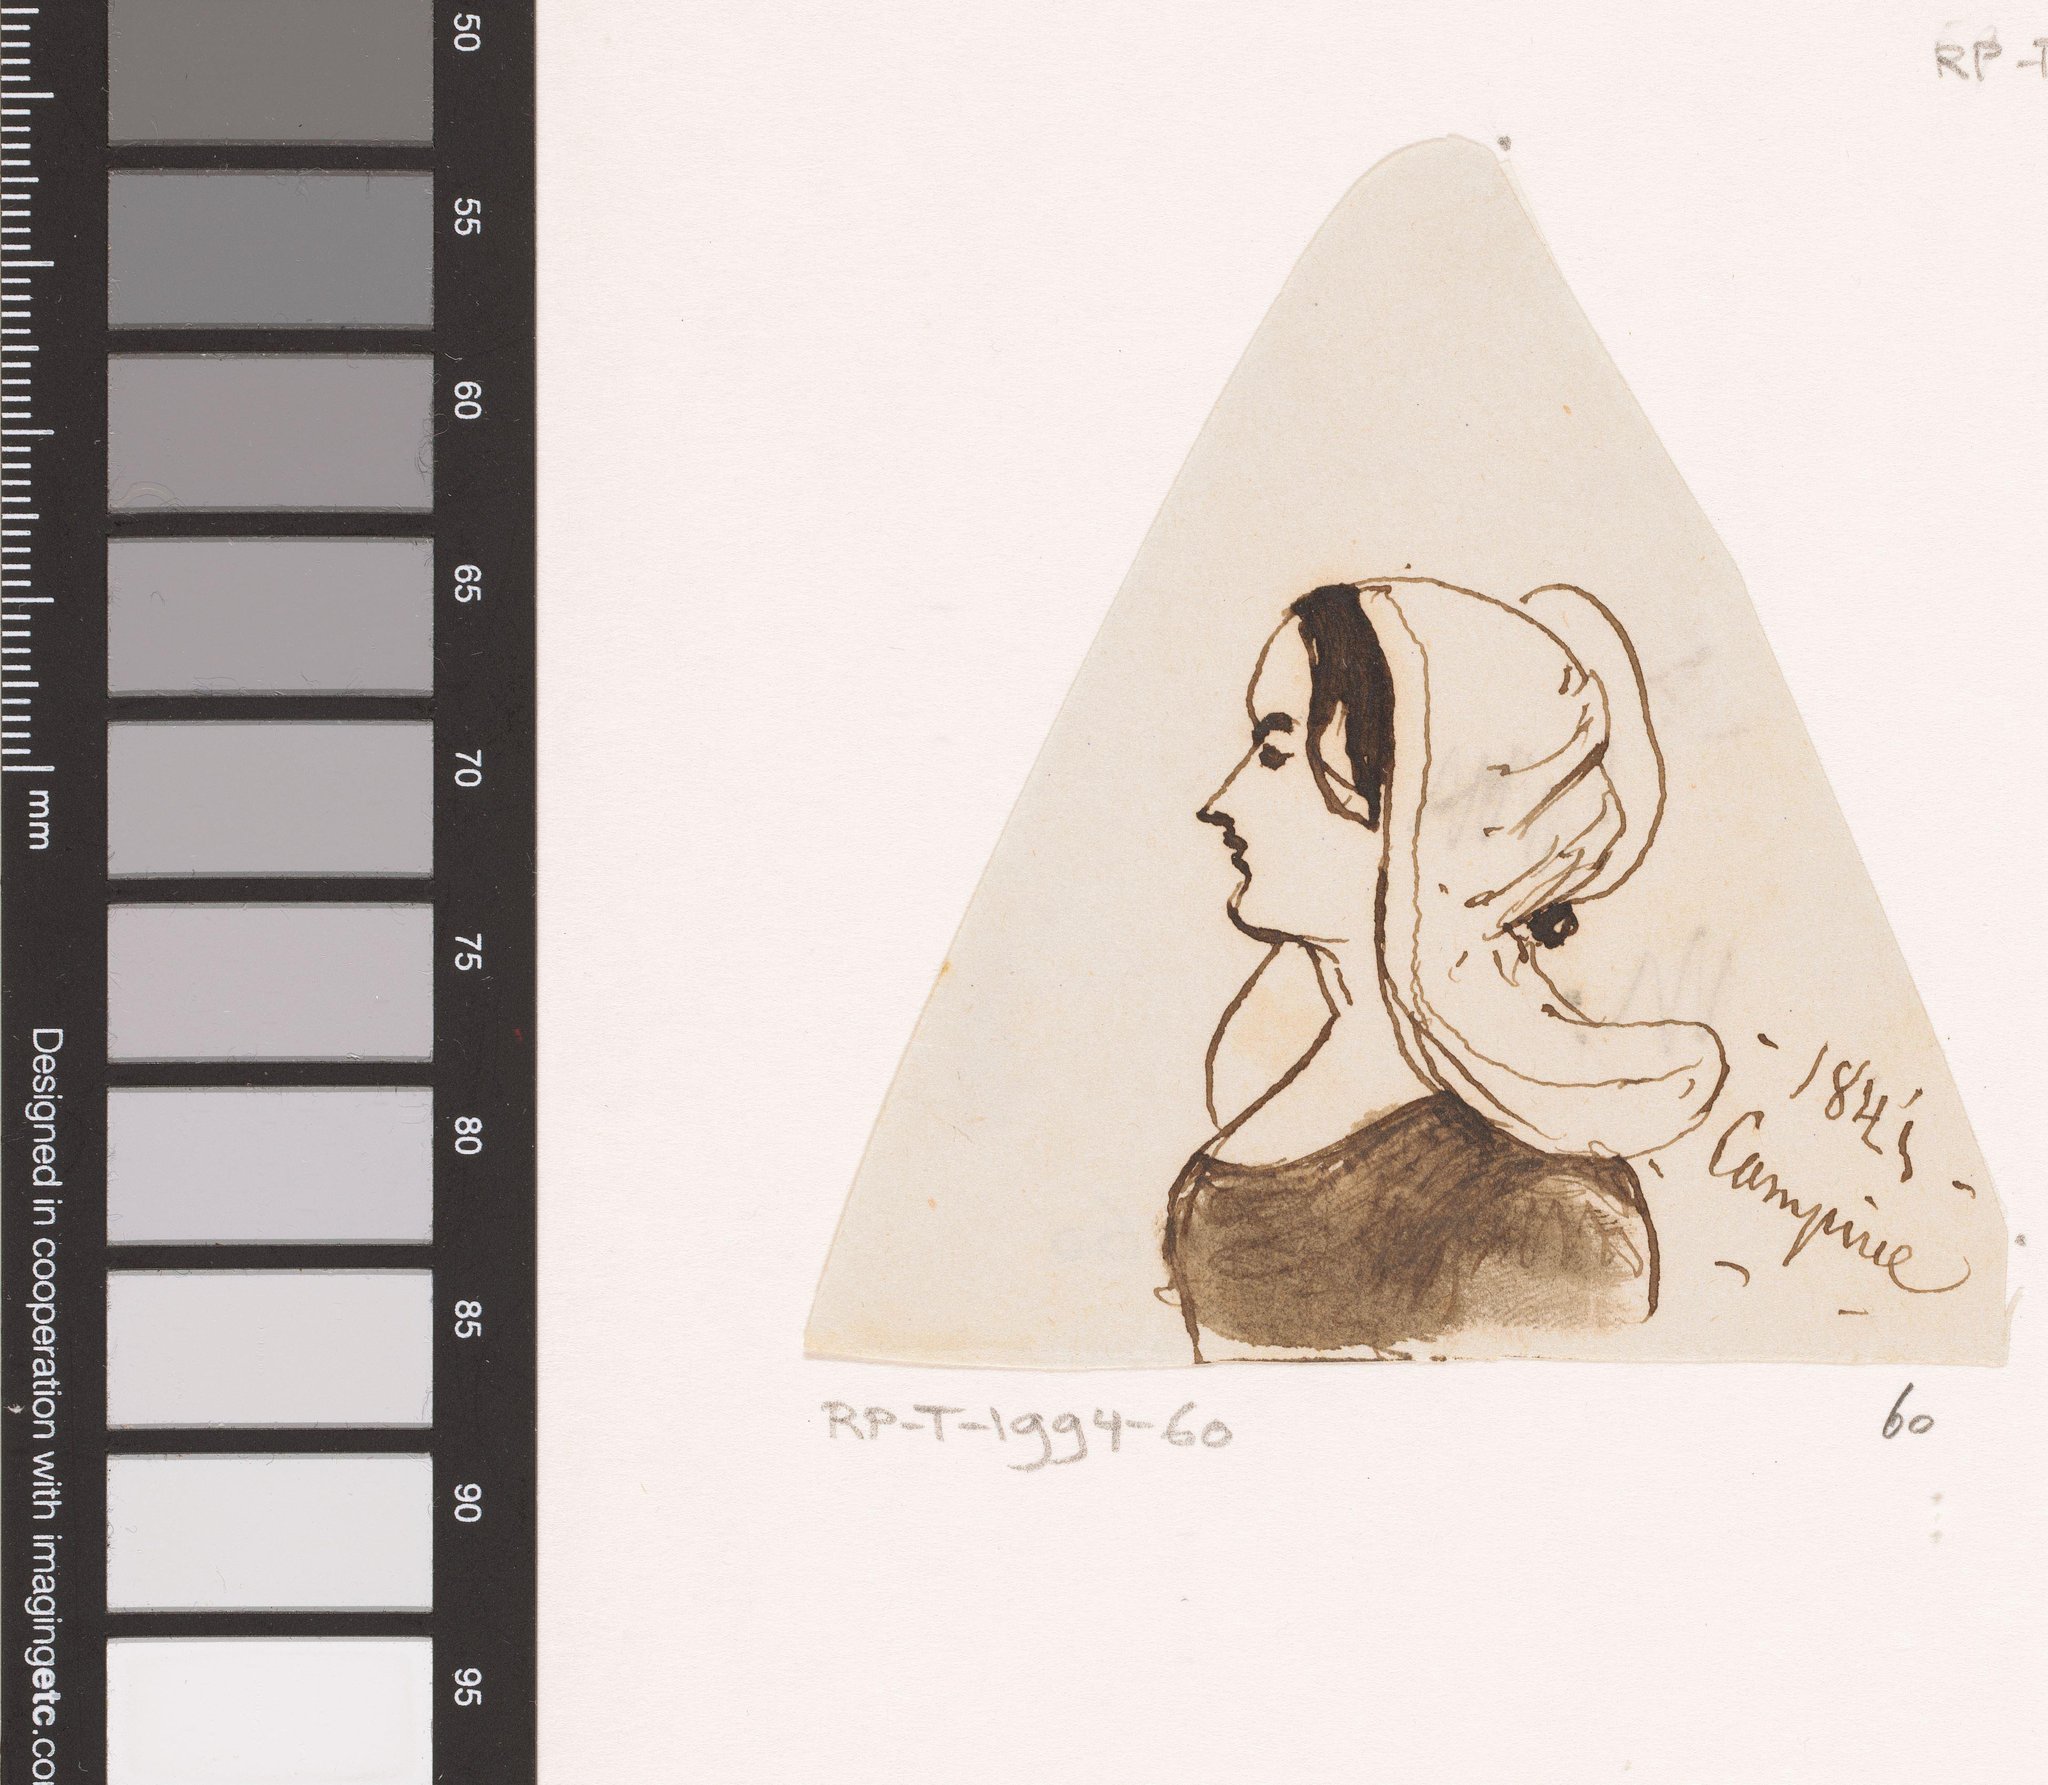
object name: drawing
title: Meisjeskopje in profiel naar links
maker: johannes tavenraat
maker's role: draughtsman, painter, print maker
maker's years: 1809-1881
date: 1845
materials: ink, paper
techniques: brush, pen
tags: head-gear, folk costume, regional costume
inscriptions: inscription: ‘1845 / Campine’